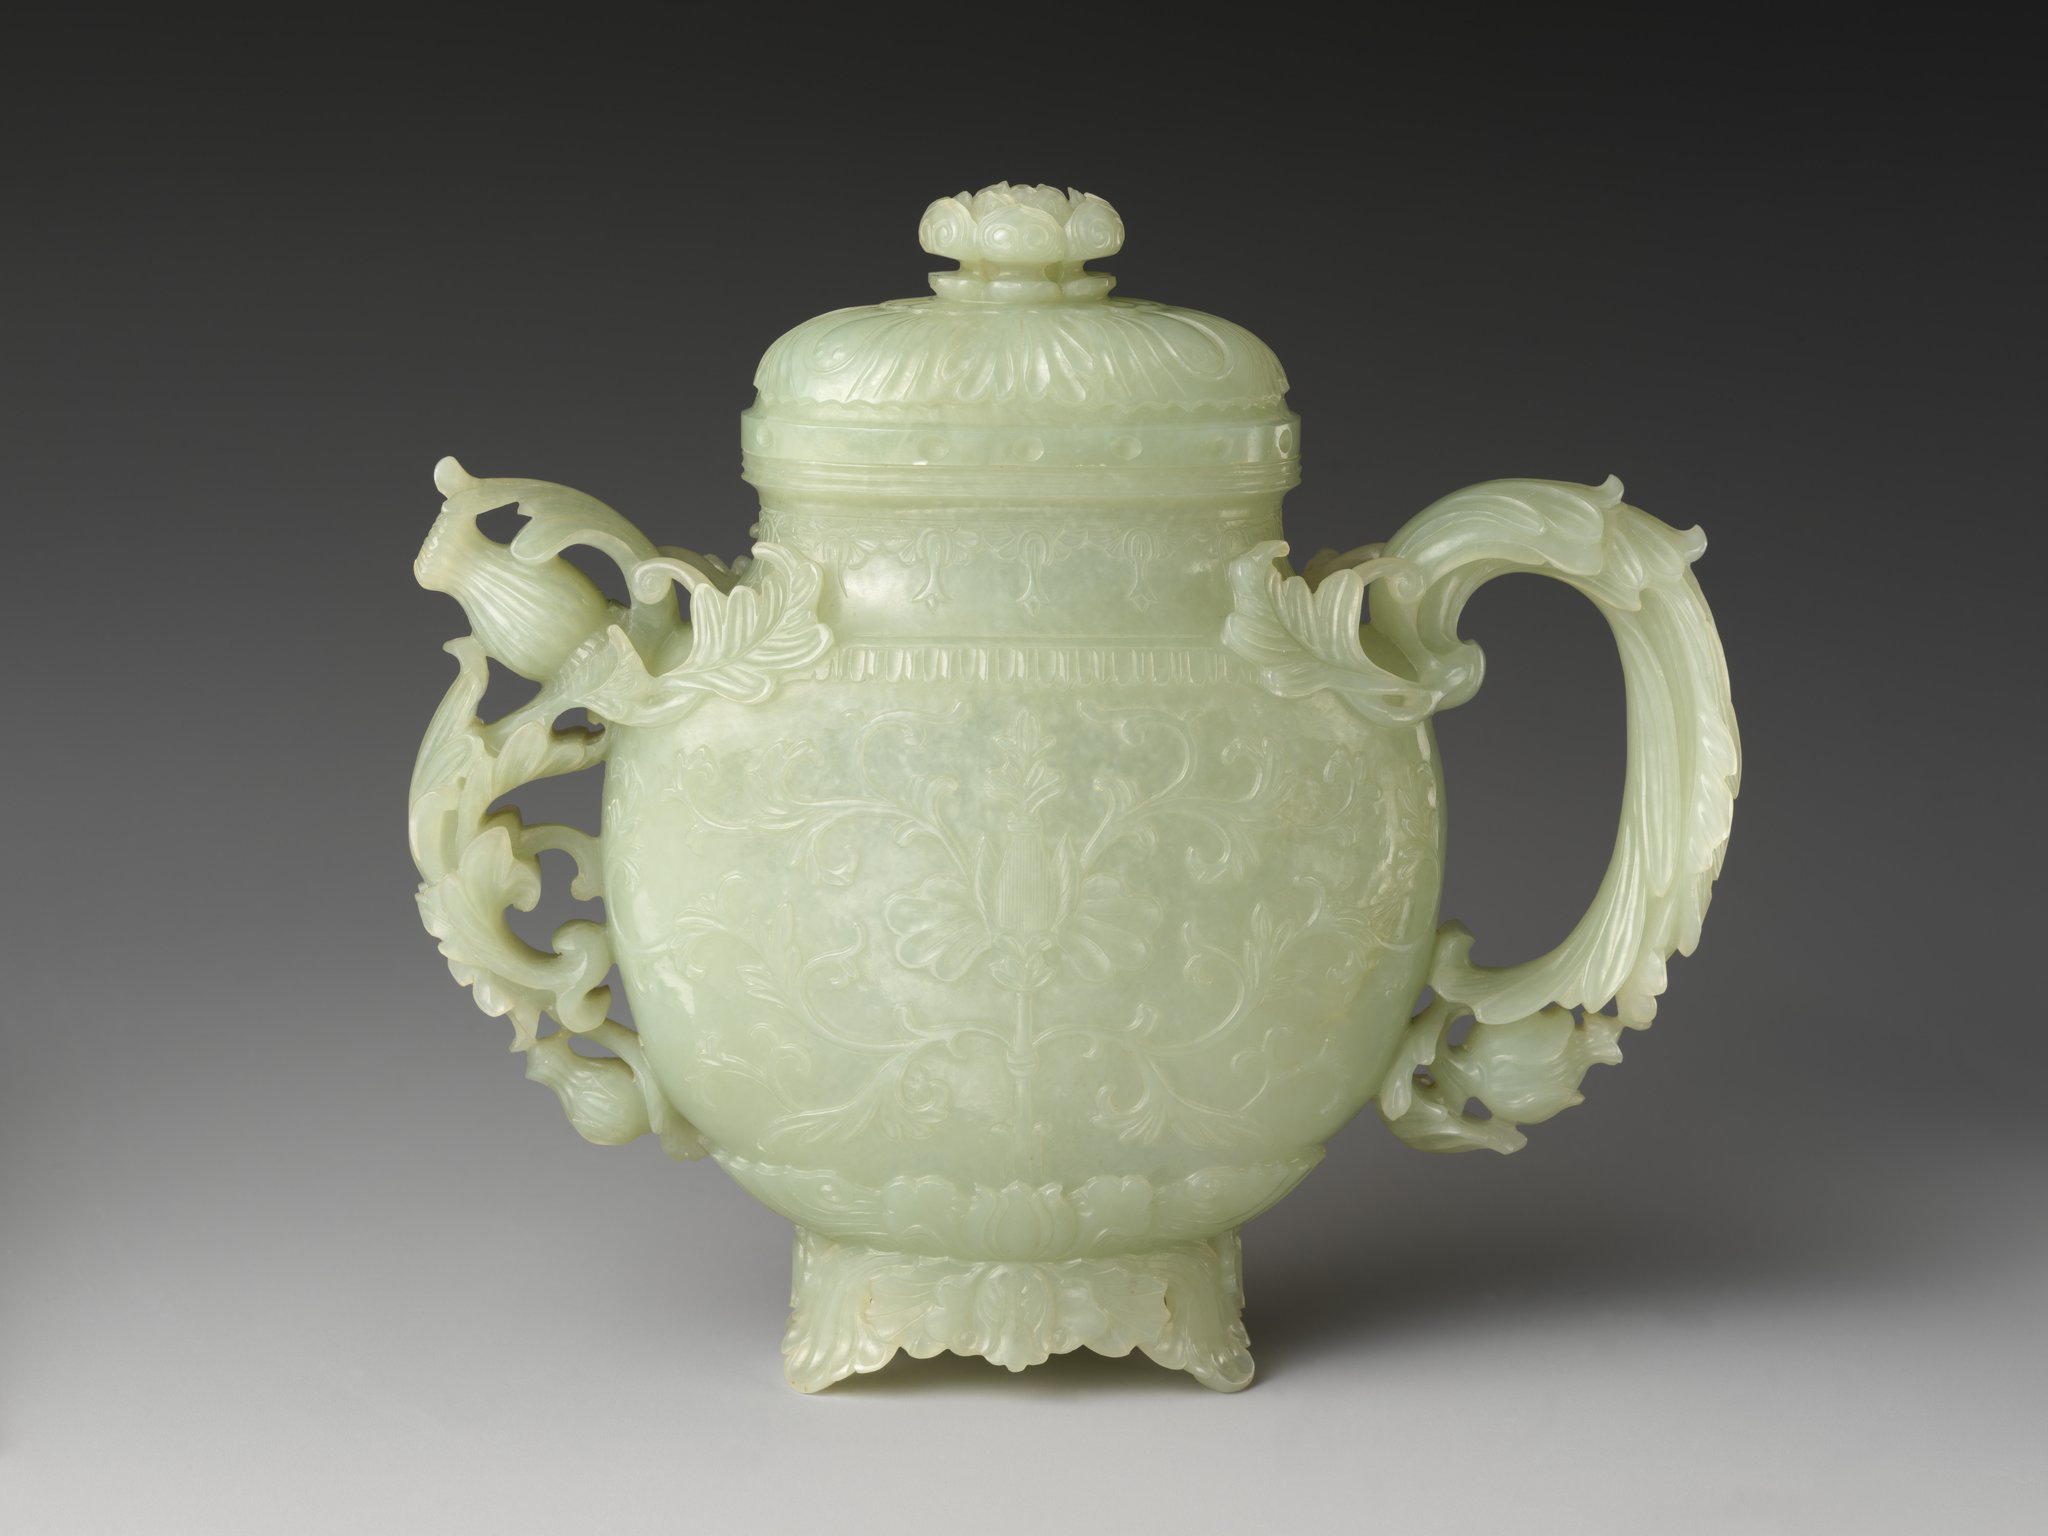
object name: ewer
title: Ewer with floral design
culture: chinese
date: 1751-1800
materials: jade